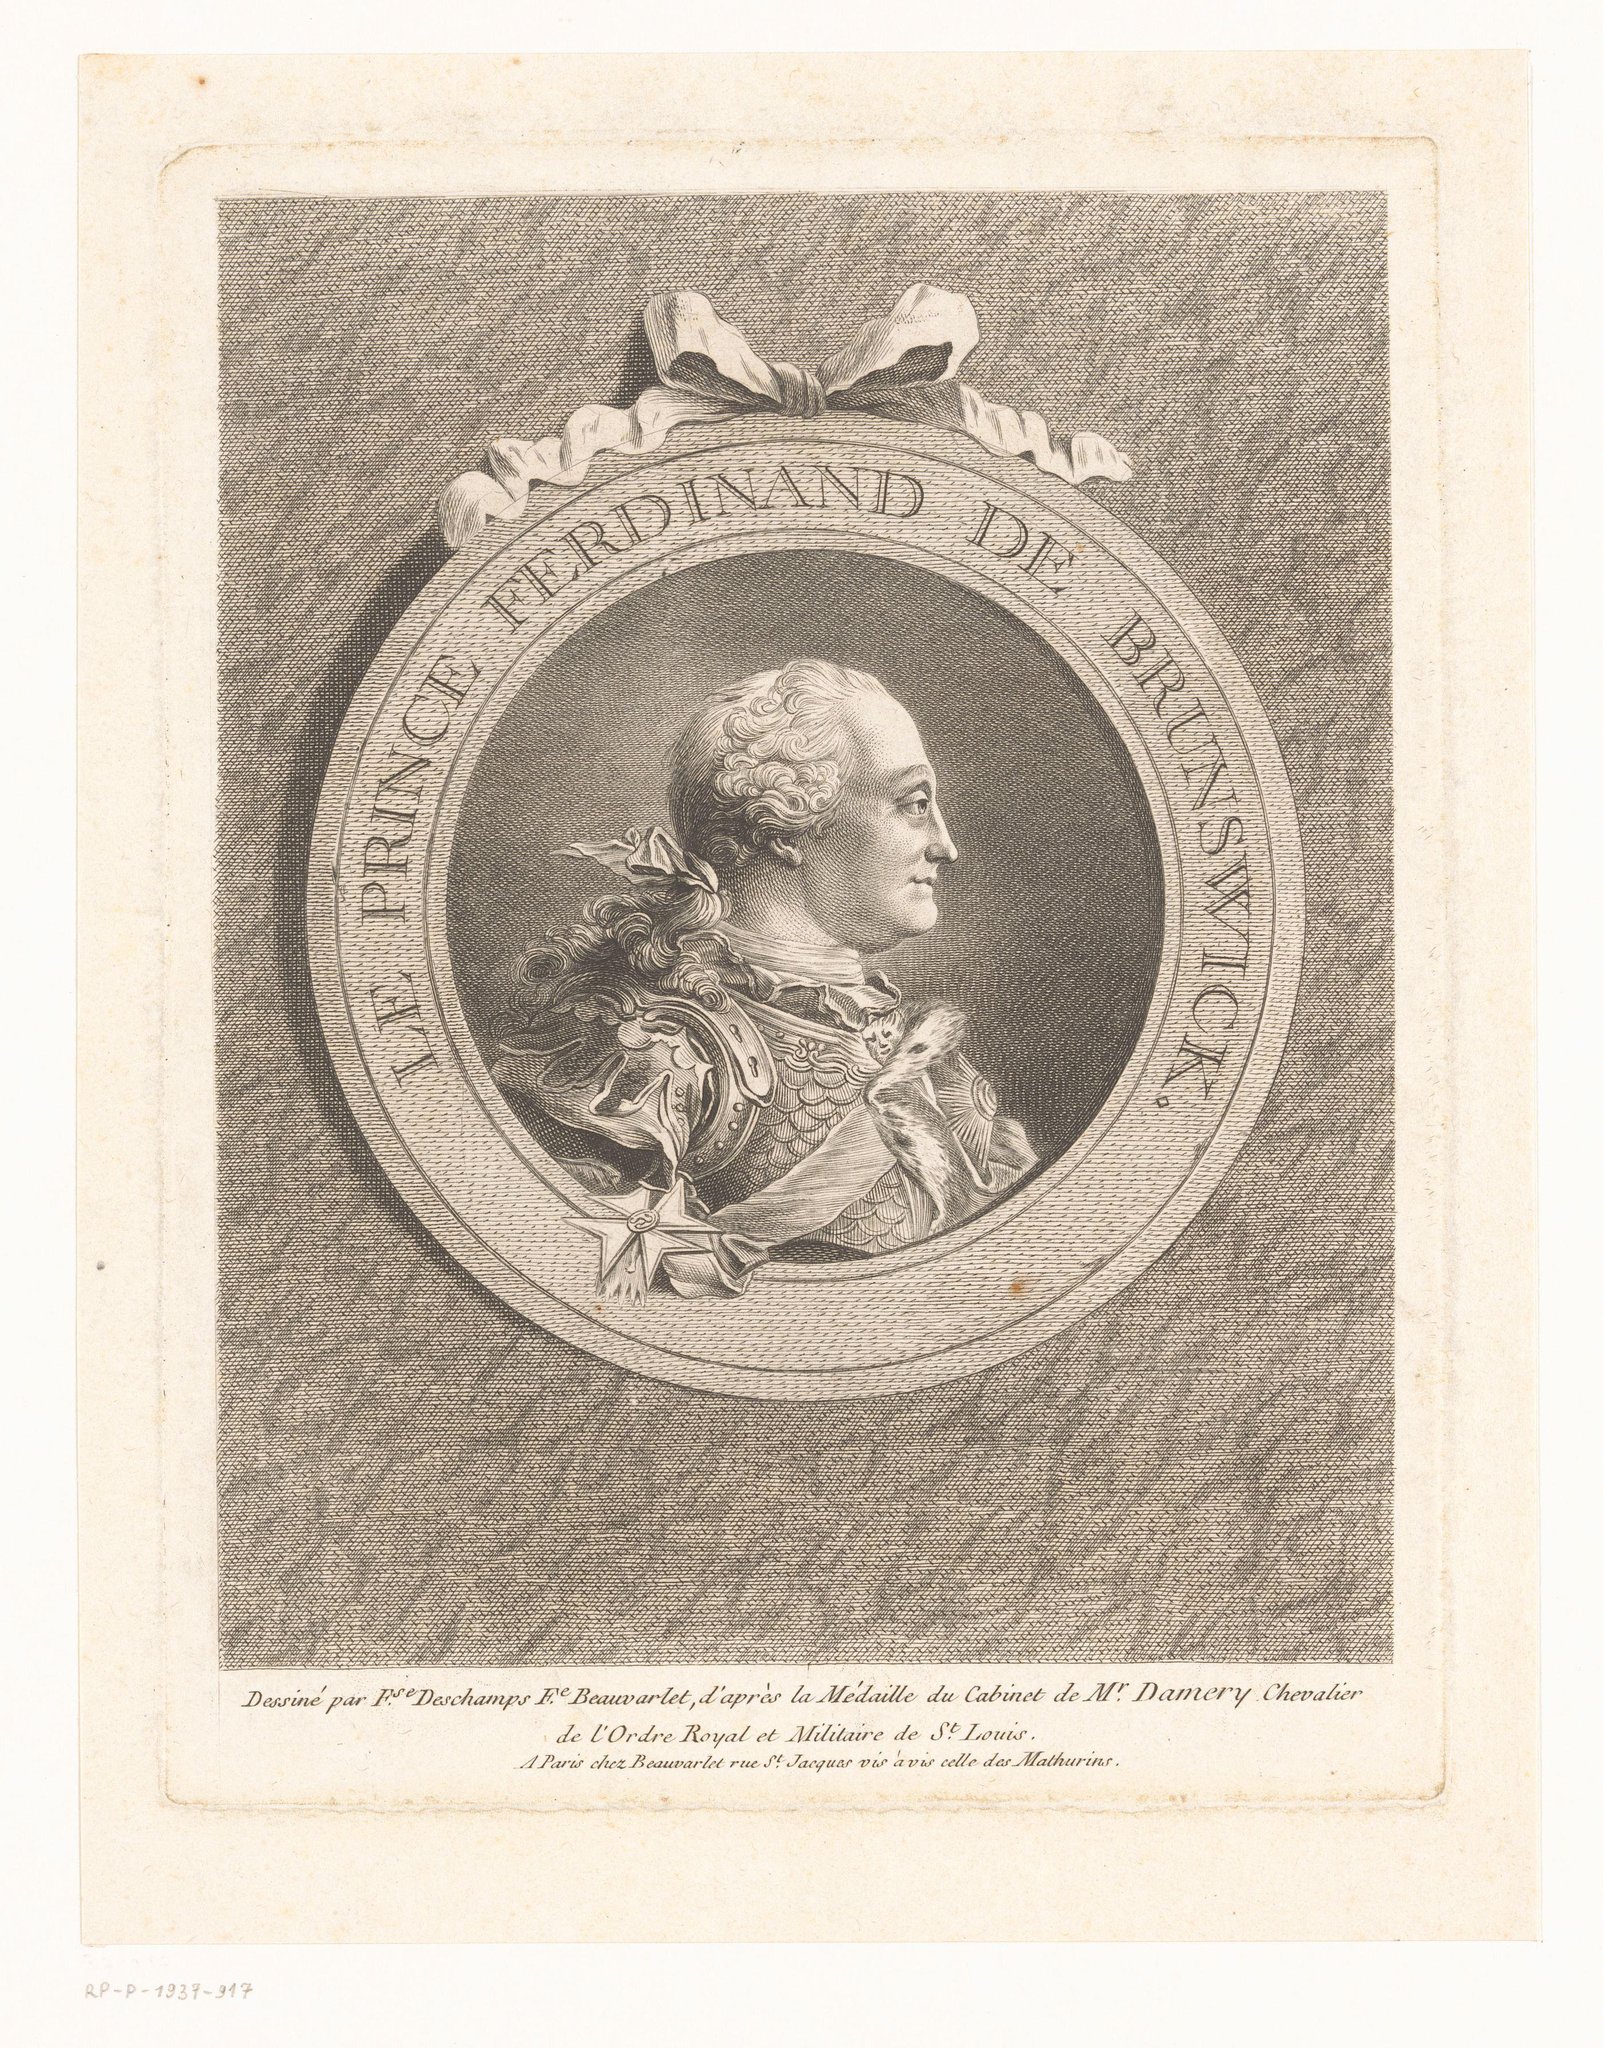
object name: print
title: Portret van Karel Willem Ferdinand van Brunswijk-Wolfenbüttel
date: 1757-1769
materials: paper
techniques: engraving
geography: paris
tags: karel willem ferdinand hertog van brunswijk-wolfenbüttel, ornament ~ medallion, historical persons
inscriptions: collector's mark: Lugt 2228, inscription: ‘Hertog Karel Willem Ferdinand van Brunswijk, zoon van Hertog Karel van (...)’